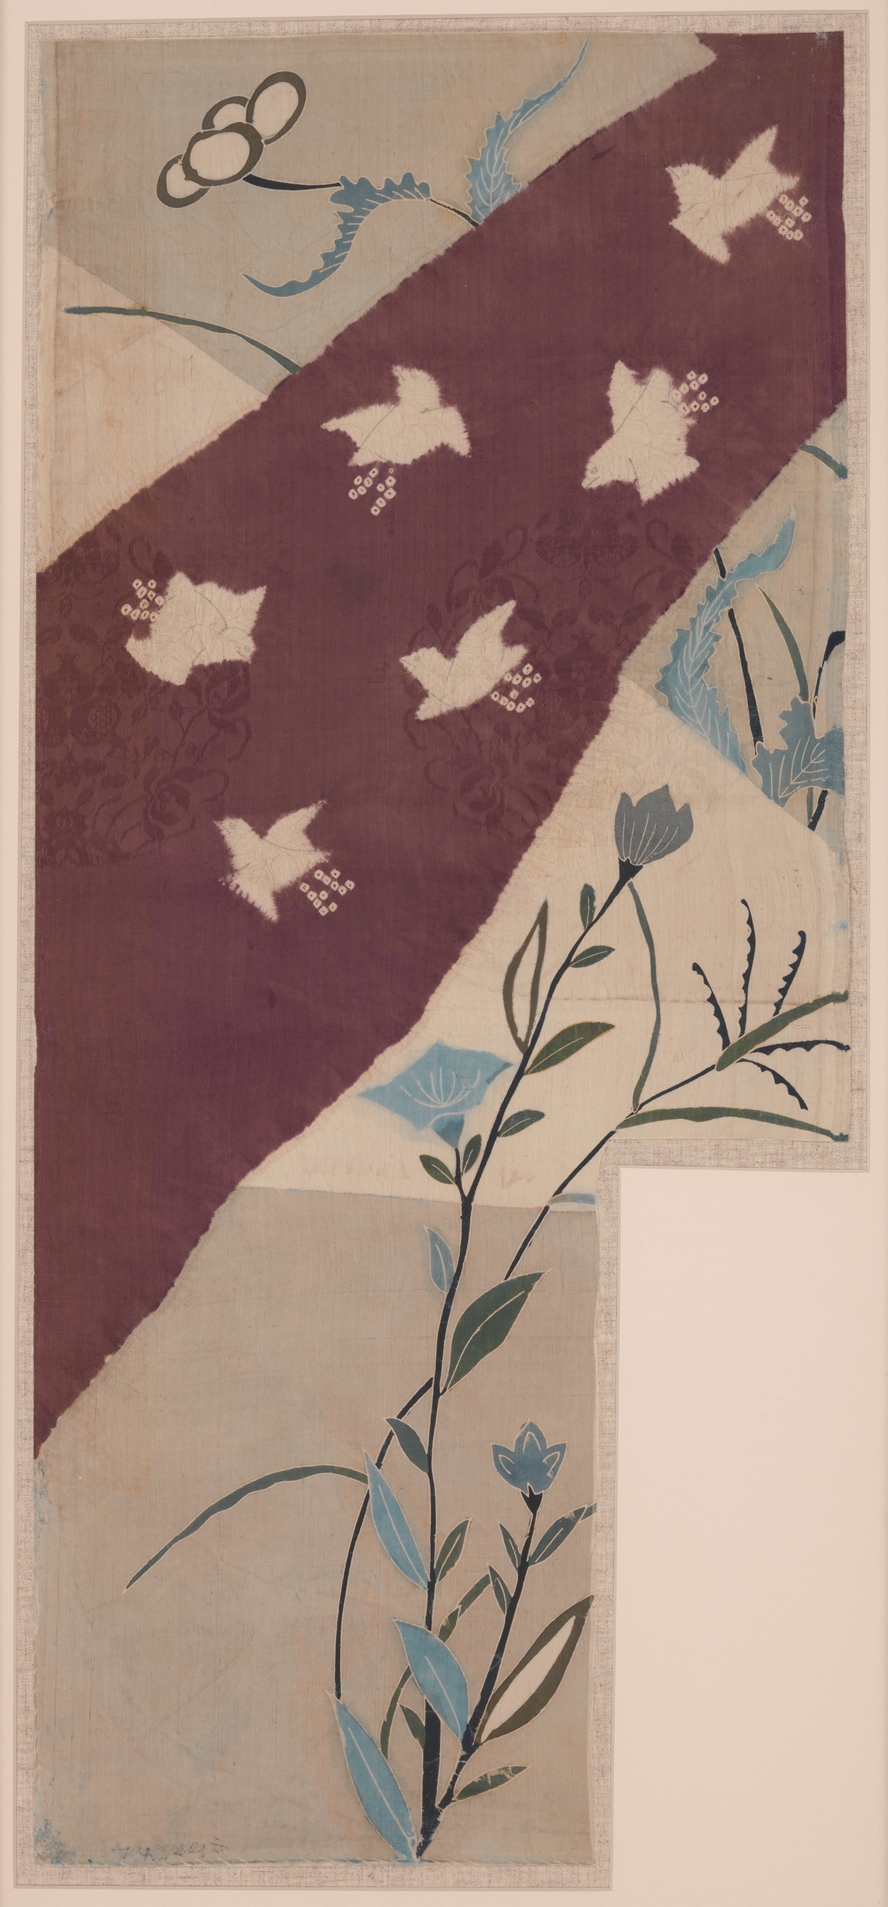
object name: piece from a kosode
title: Pieces from a Robe (Kosode) with Autumn Grasses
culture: japanese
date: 1701-1750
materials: paste, silk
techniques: dyeing, painting, weave, resist, stitching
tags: flowers,plants